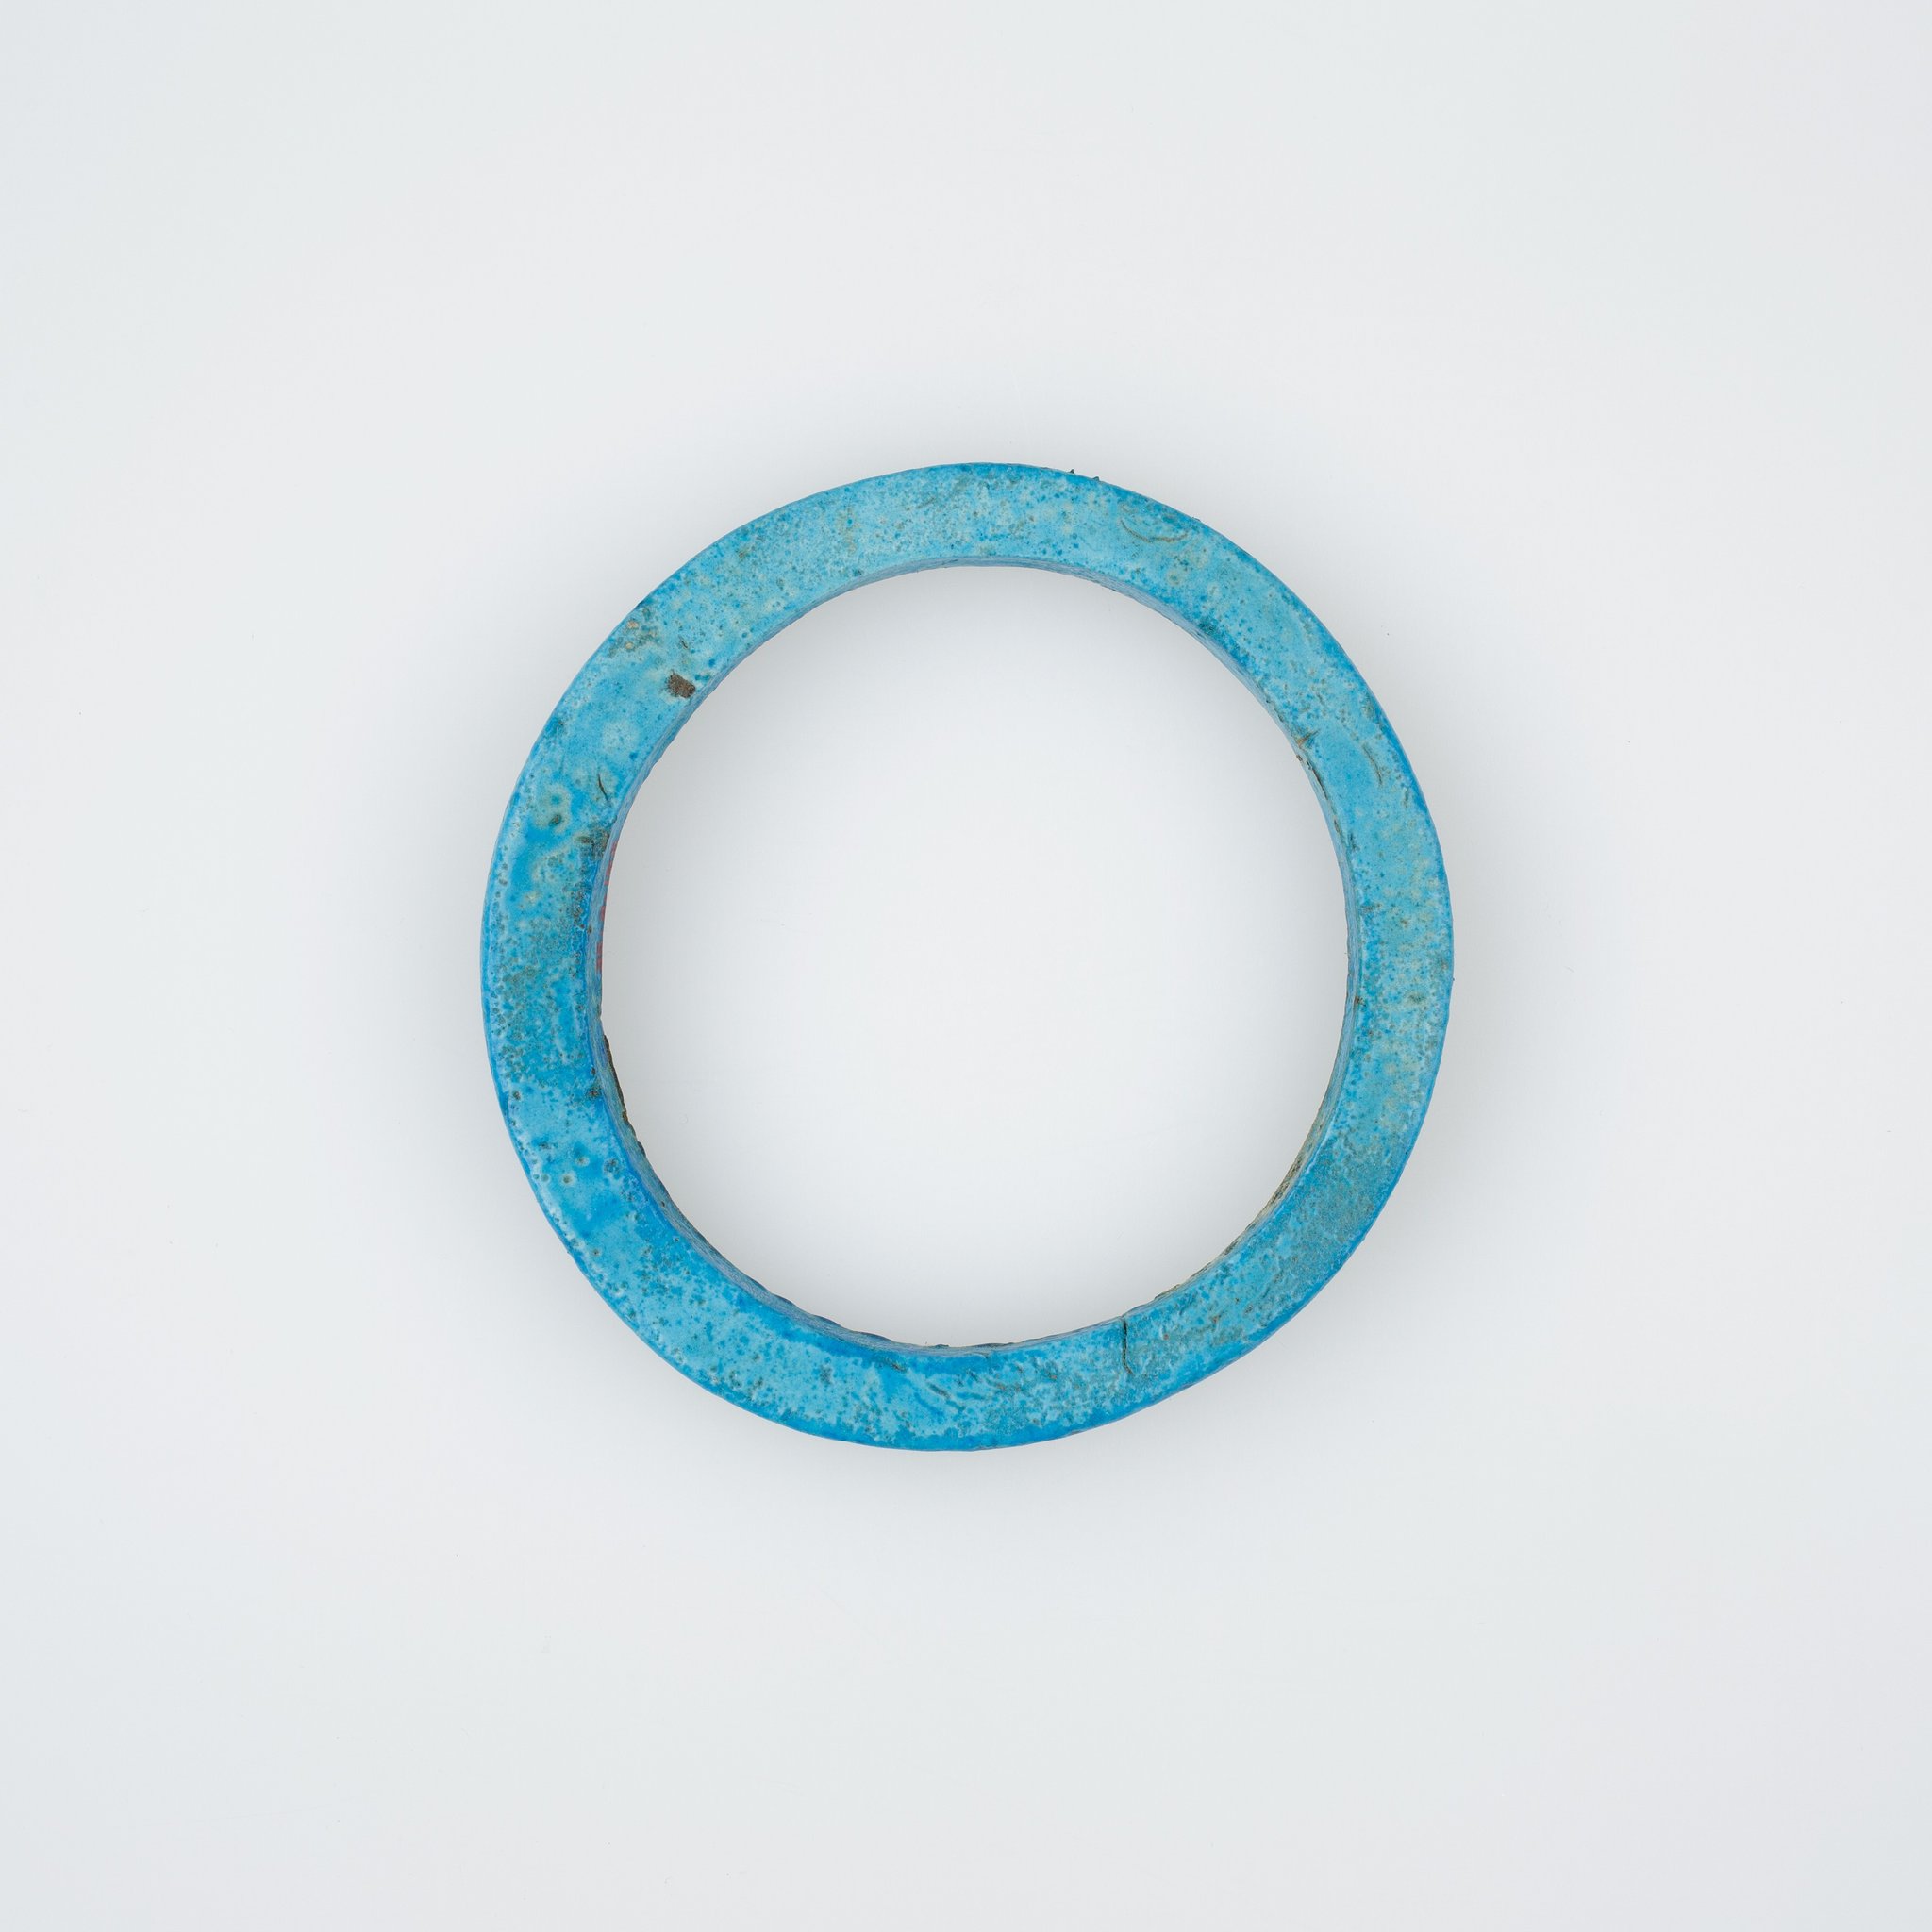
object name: armlet, a'a, amenhotep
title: Armlet of Amenhotep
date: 1479-1458 BCE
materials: faience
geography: egypt